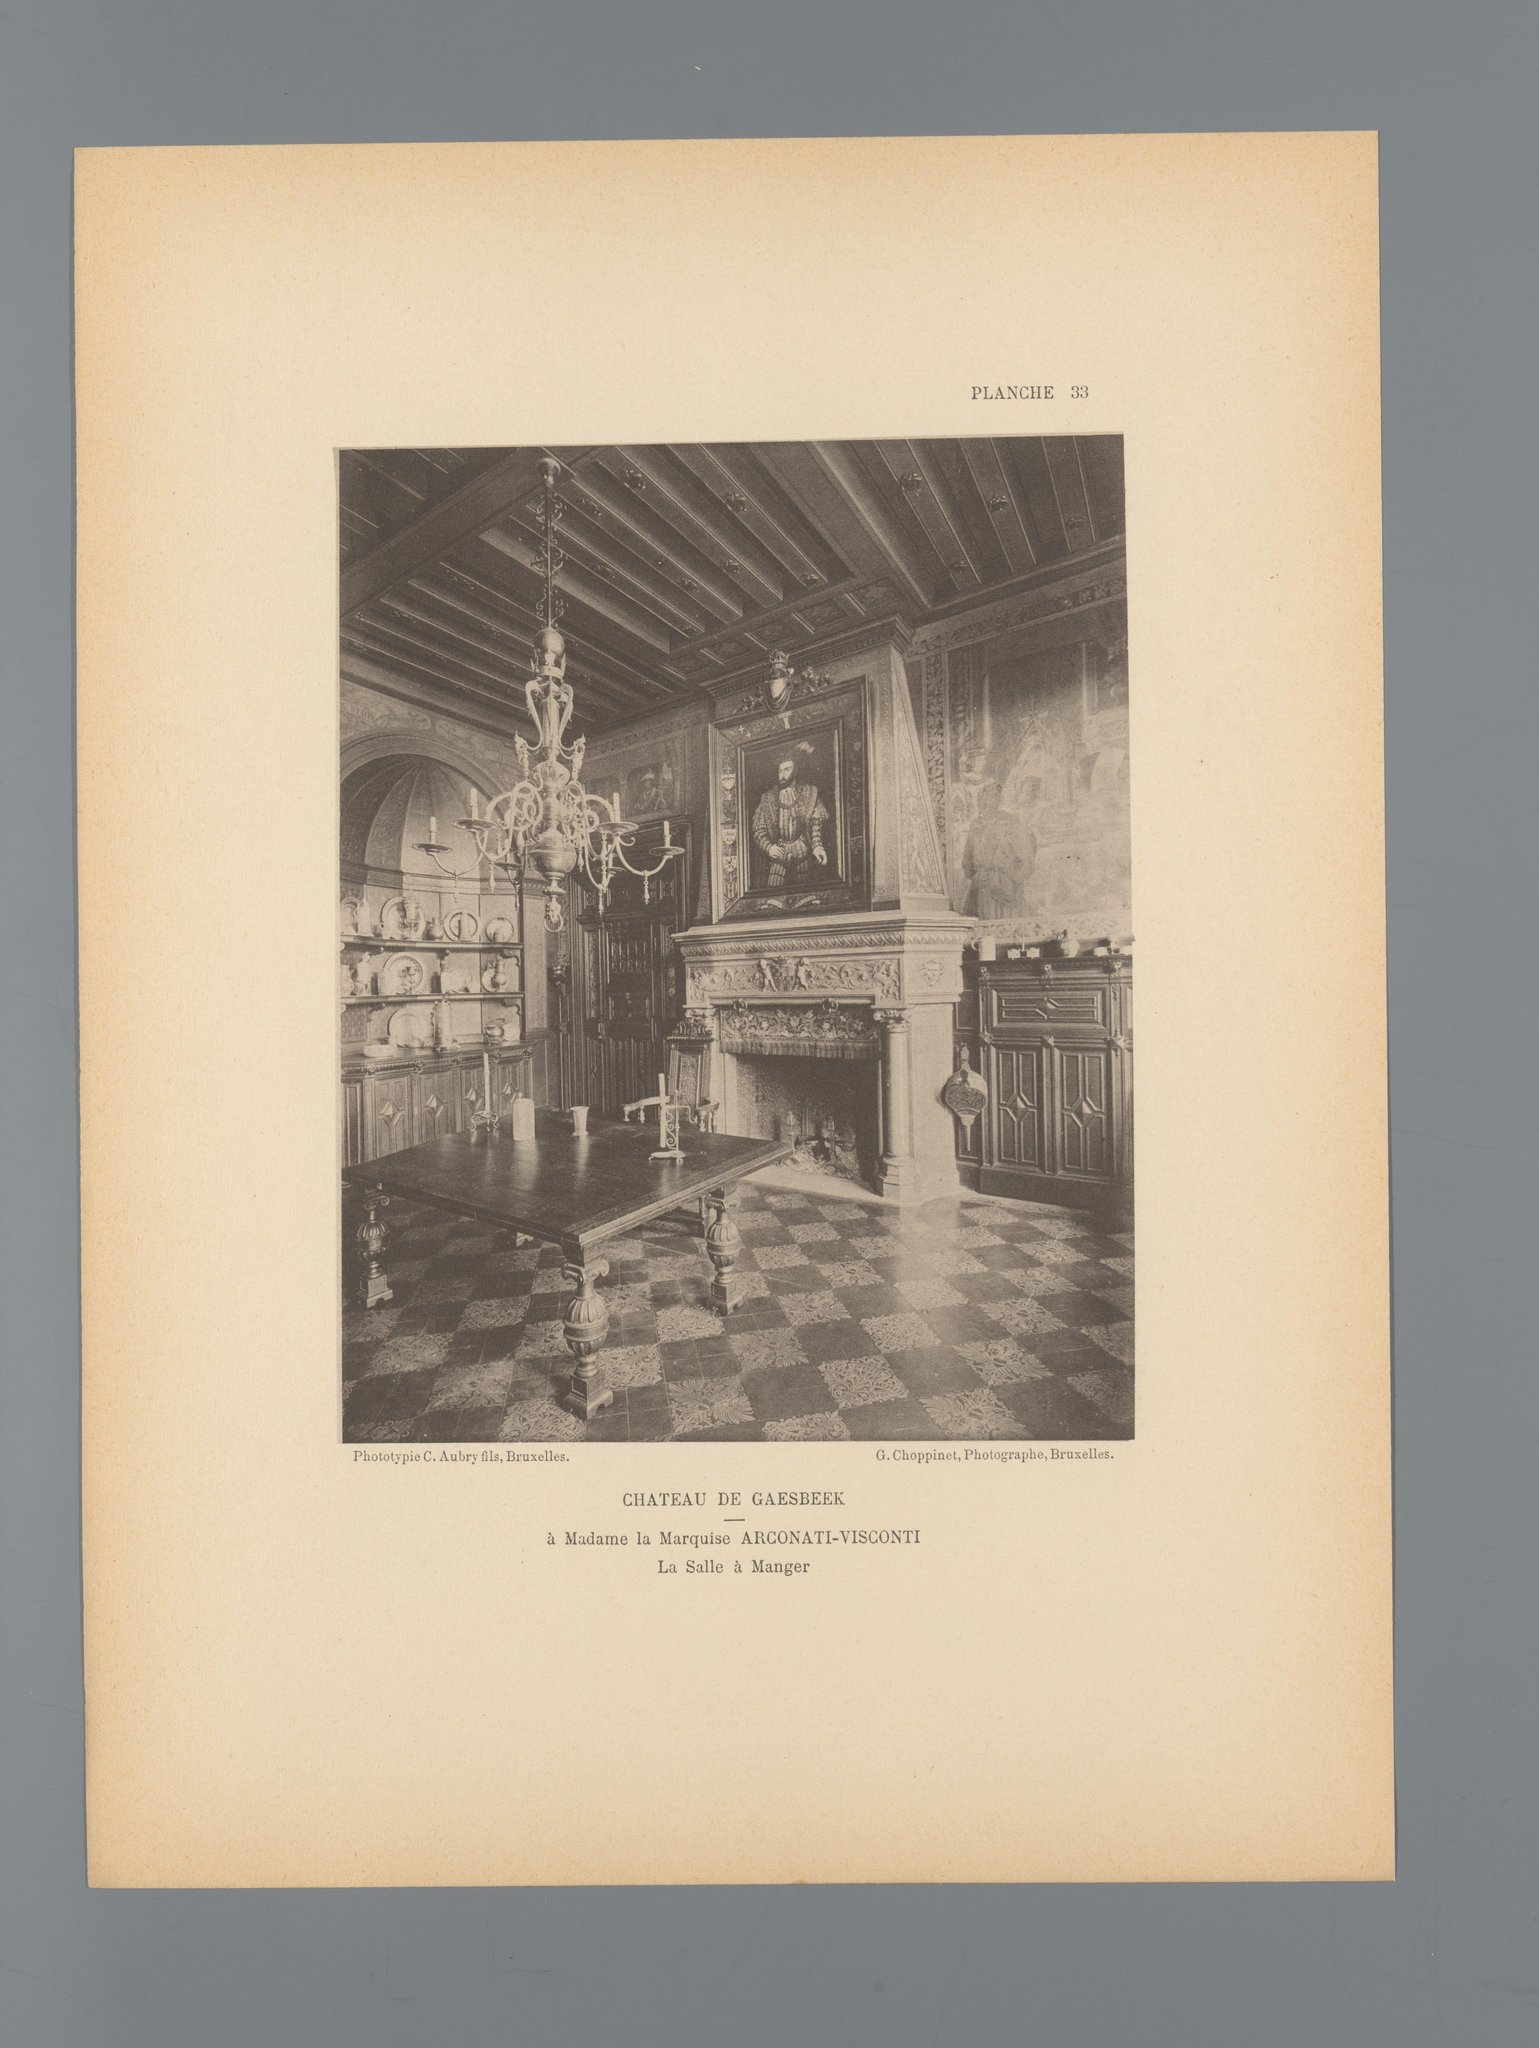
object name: photomechanical print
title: Chateau de Gaesbeek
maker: gustave choppinet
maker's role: fotograaf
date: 1893-1898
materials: paper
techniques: photograph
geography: brussels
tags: castle, dining-room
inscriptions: inscription: ‘à Madame la Marquise ARCONATI-VISCONTI/ La Salle à Manger’, number: ‘PLANCHE 33’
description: Deze prent maakt deel uit van een omslag met 89 prenten en 5 tekstbladen.